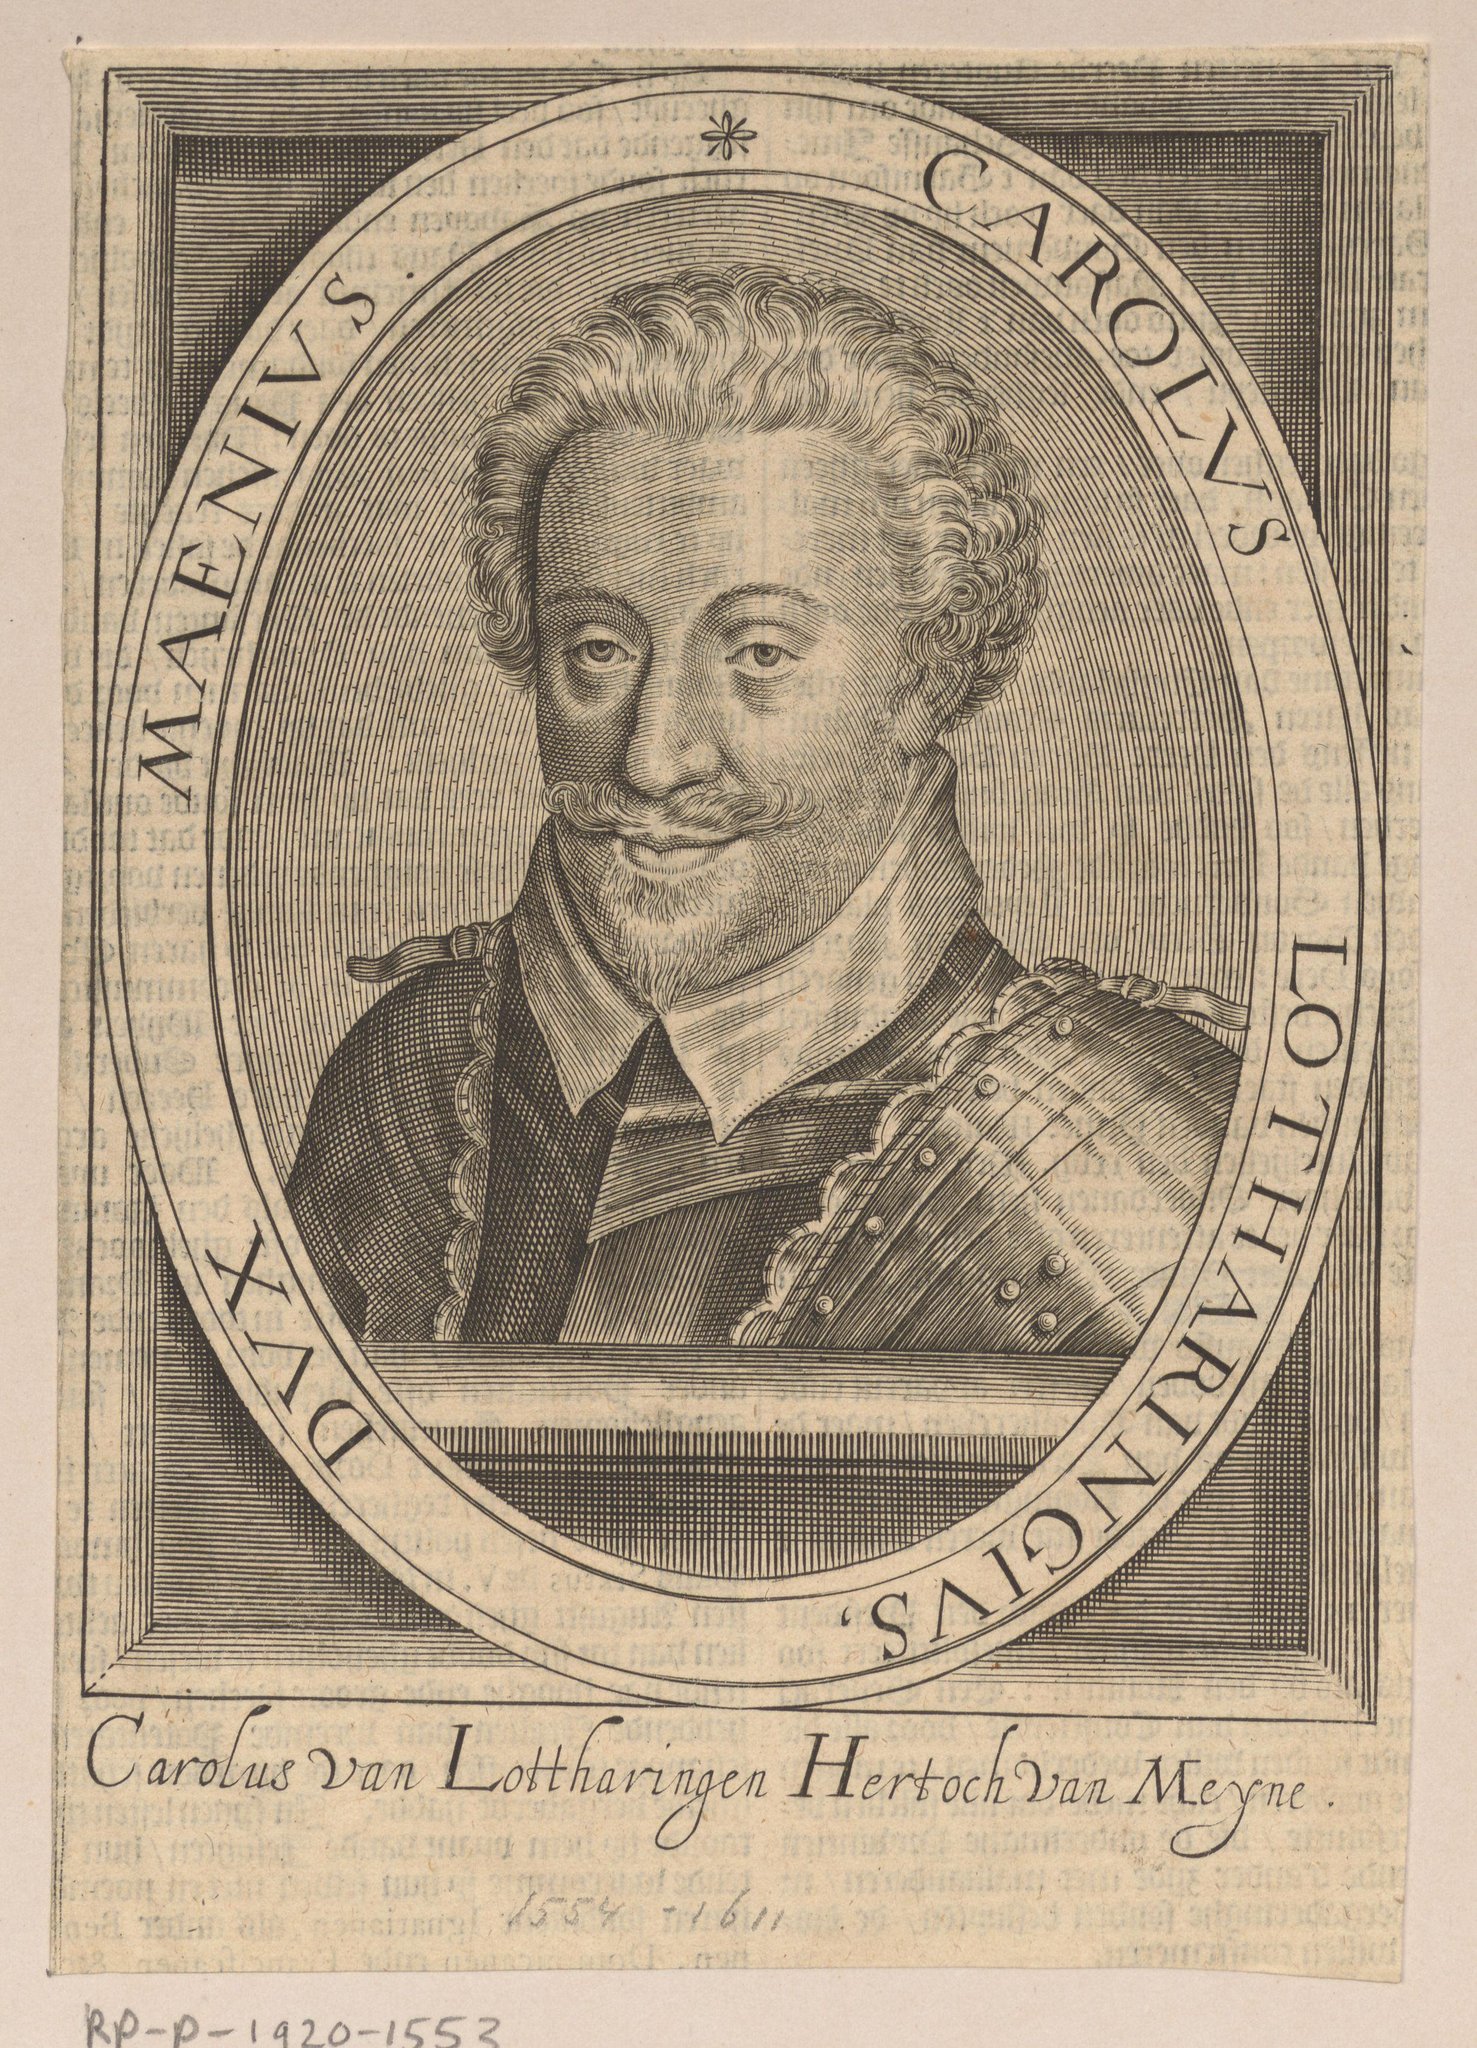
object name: print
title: Carolus van Lottharingen Hertoch van Meyne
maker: Anonymous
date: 1600-1650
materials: paper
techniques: engraving, letterpress printing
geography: northern netherlands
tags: armour, historical persons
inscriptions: collector's mark: Lugt 2228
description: Prent komt uit een editie van Van Meterens 'Historie der Neder-landscher ende haerder na-buren oorlogen (...)'.